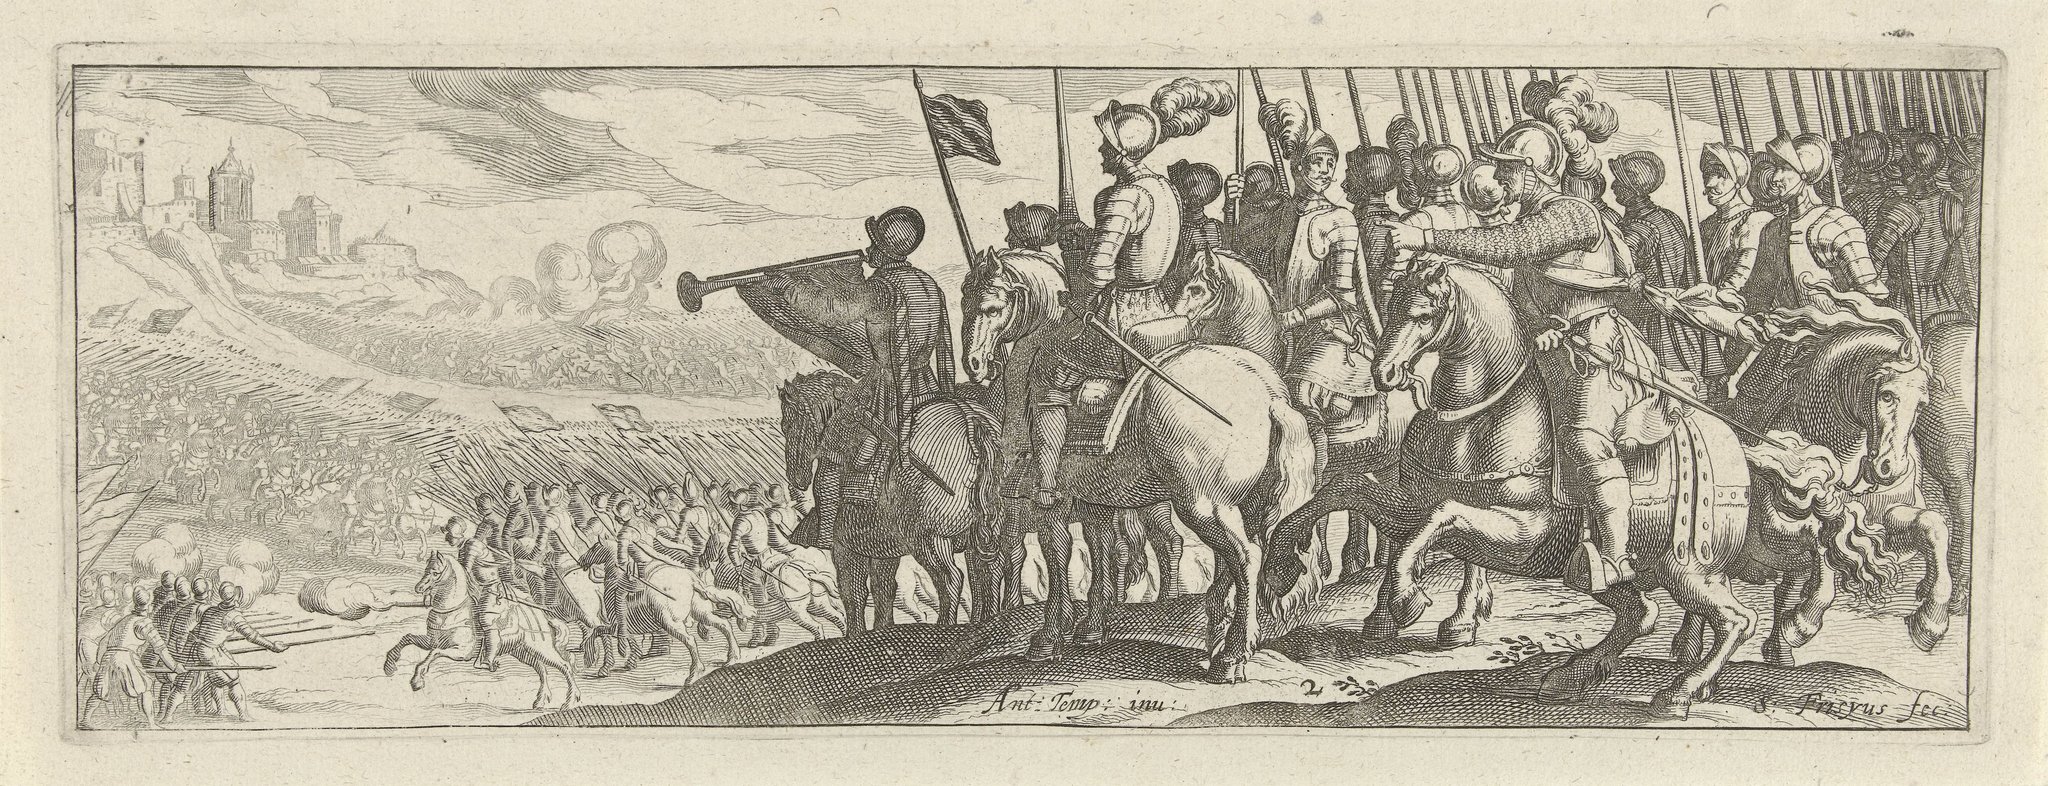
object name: print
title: Cavalerie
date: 1595-1628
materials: paper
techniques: etching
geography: northern netherlands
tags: battle, military discipline (+ cavalry, horsemen)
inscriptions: collector's mark: Lugt 2228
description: Rechts staan cavaleristen met lansen op een heuvel. Ze kijken uit op een veldslag.